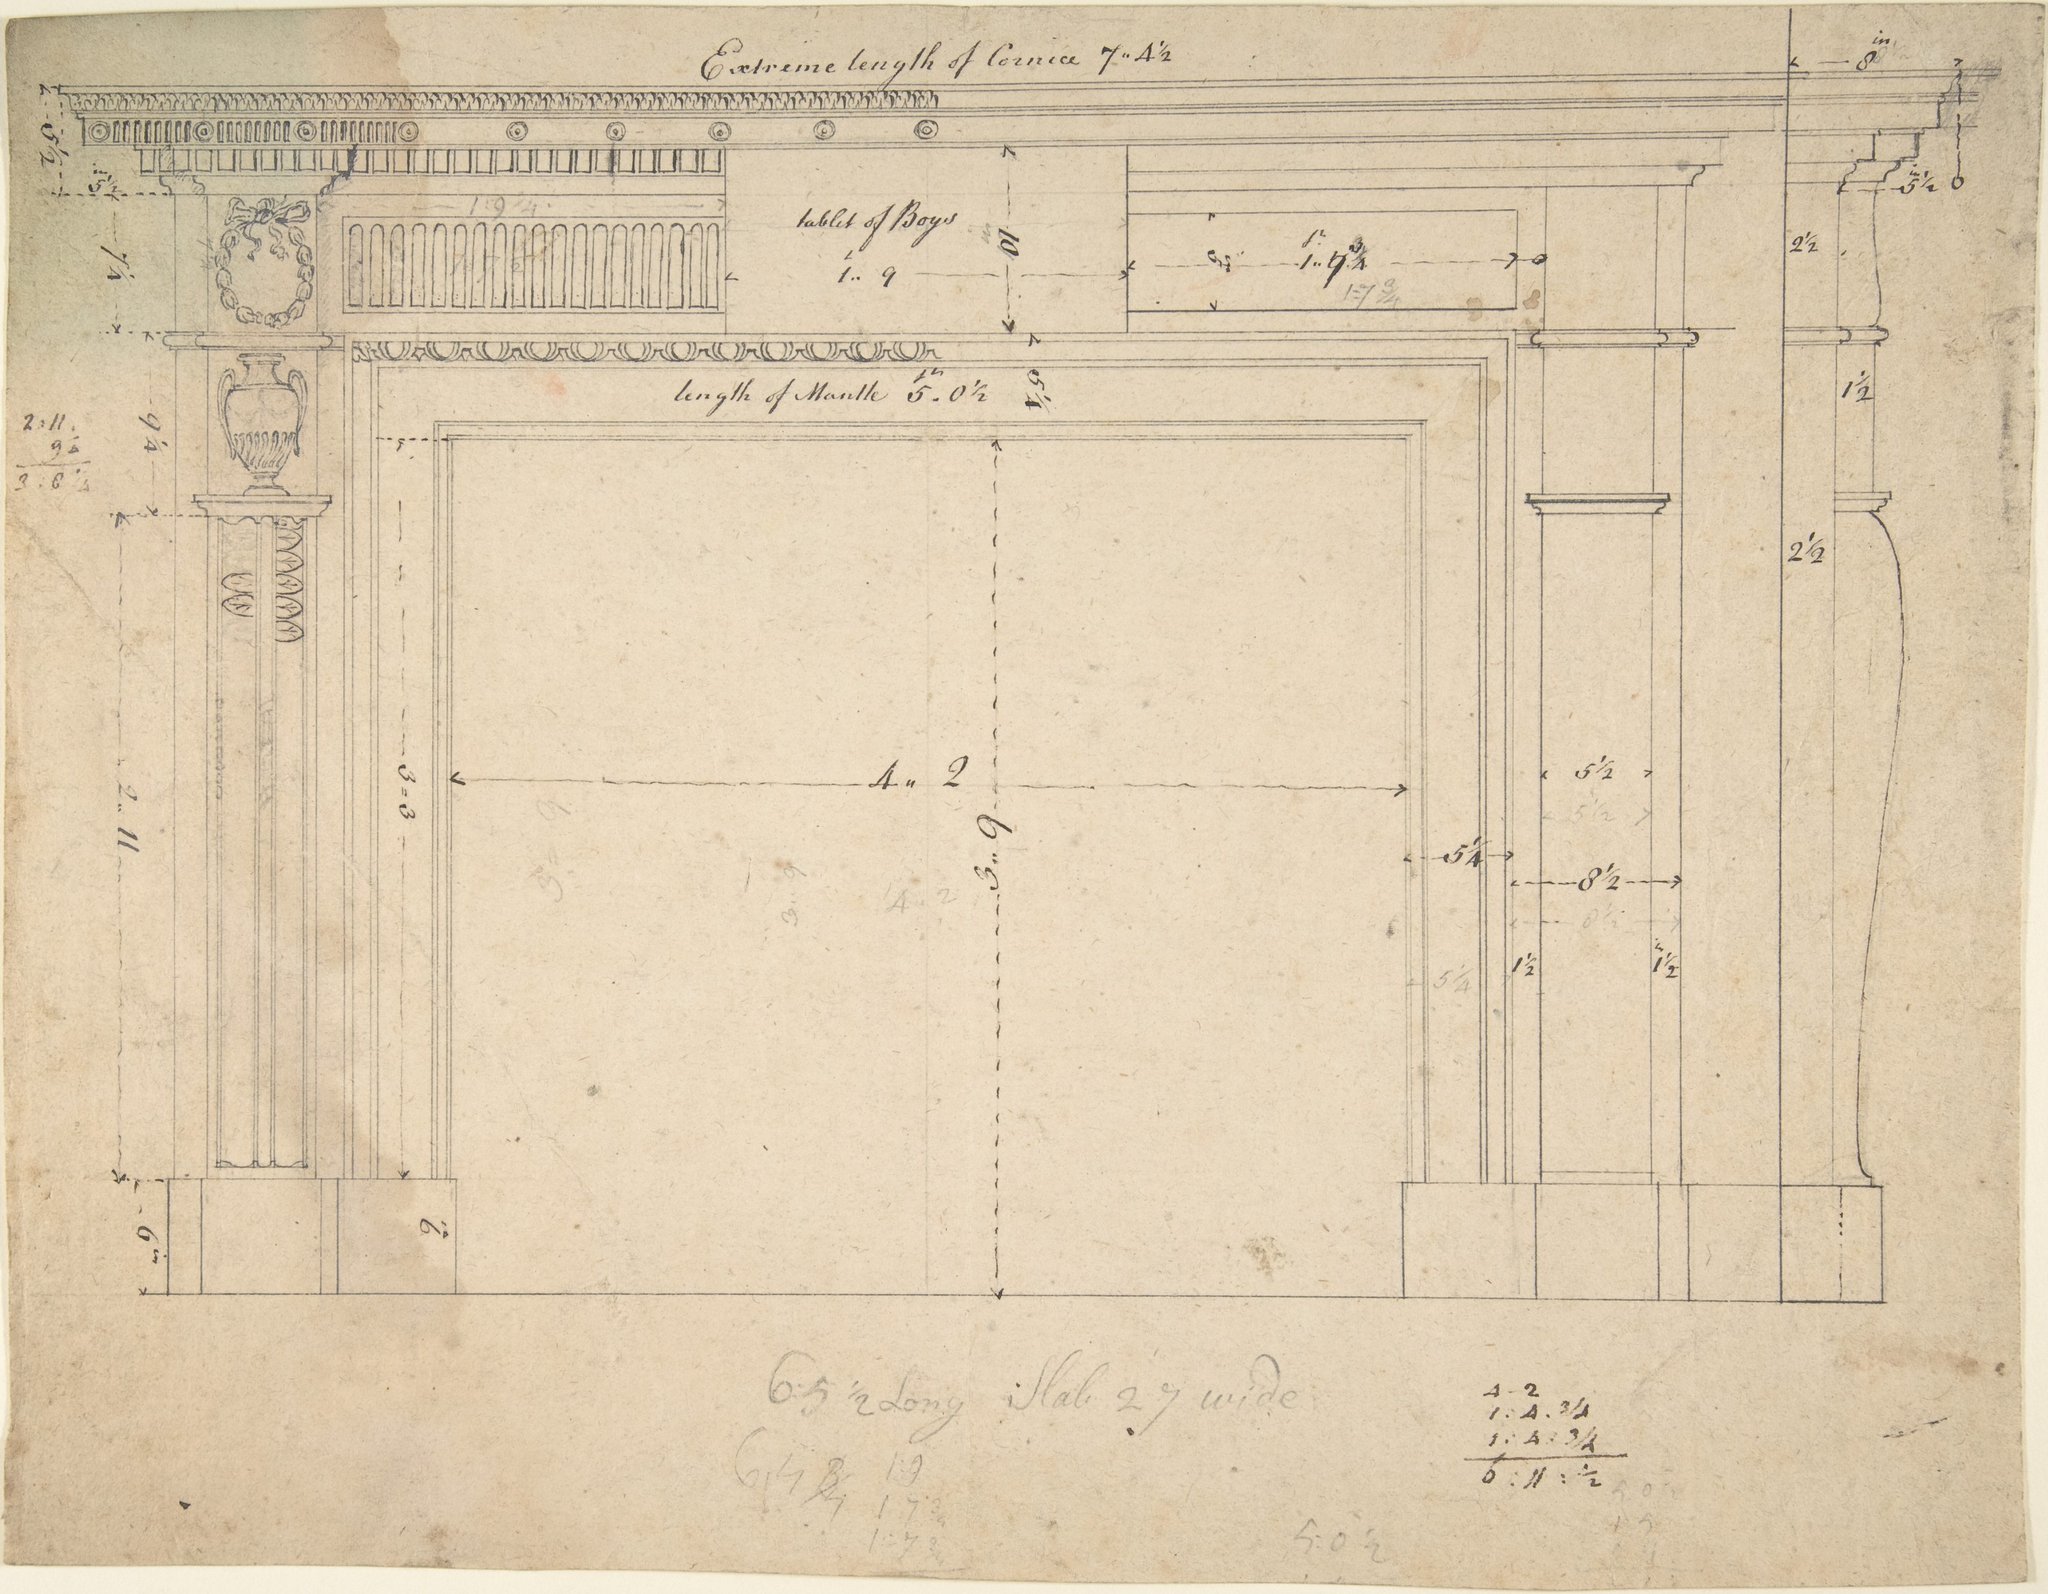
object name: drawing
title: Design for a Chimneypiece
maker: sir william chambers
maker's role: artist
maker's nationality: british, born sweden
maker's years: 1723-1796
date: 1740-1800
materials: ink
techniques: pen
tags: fireplaces